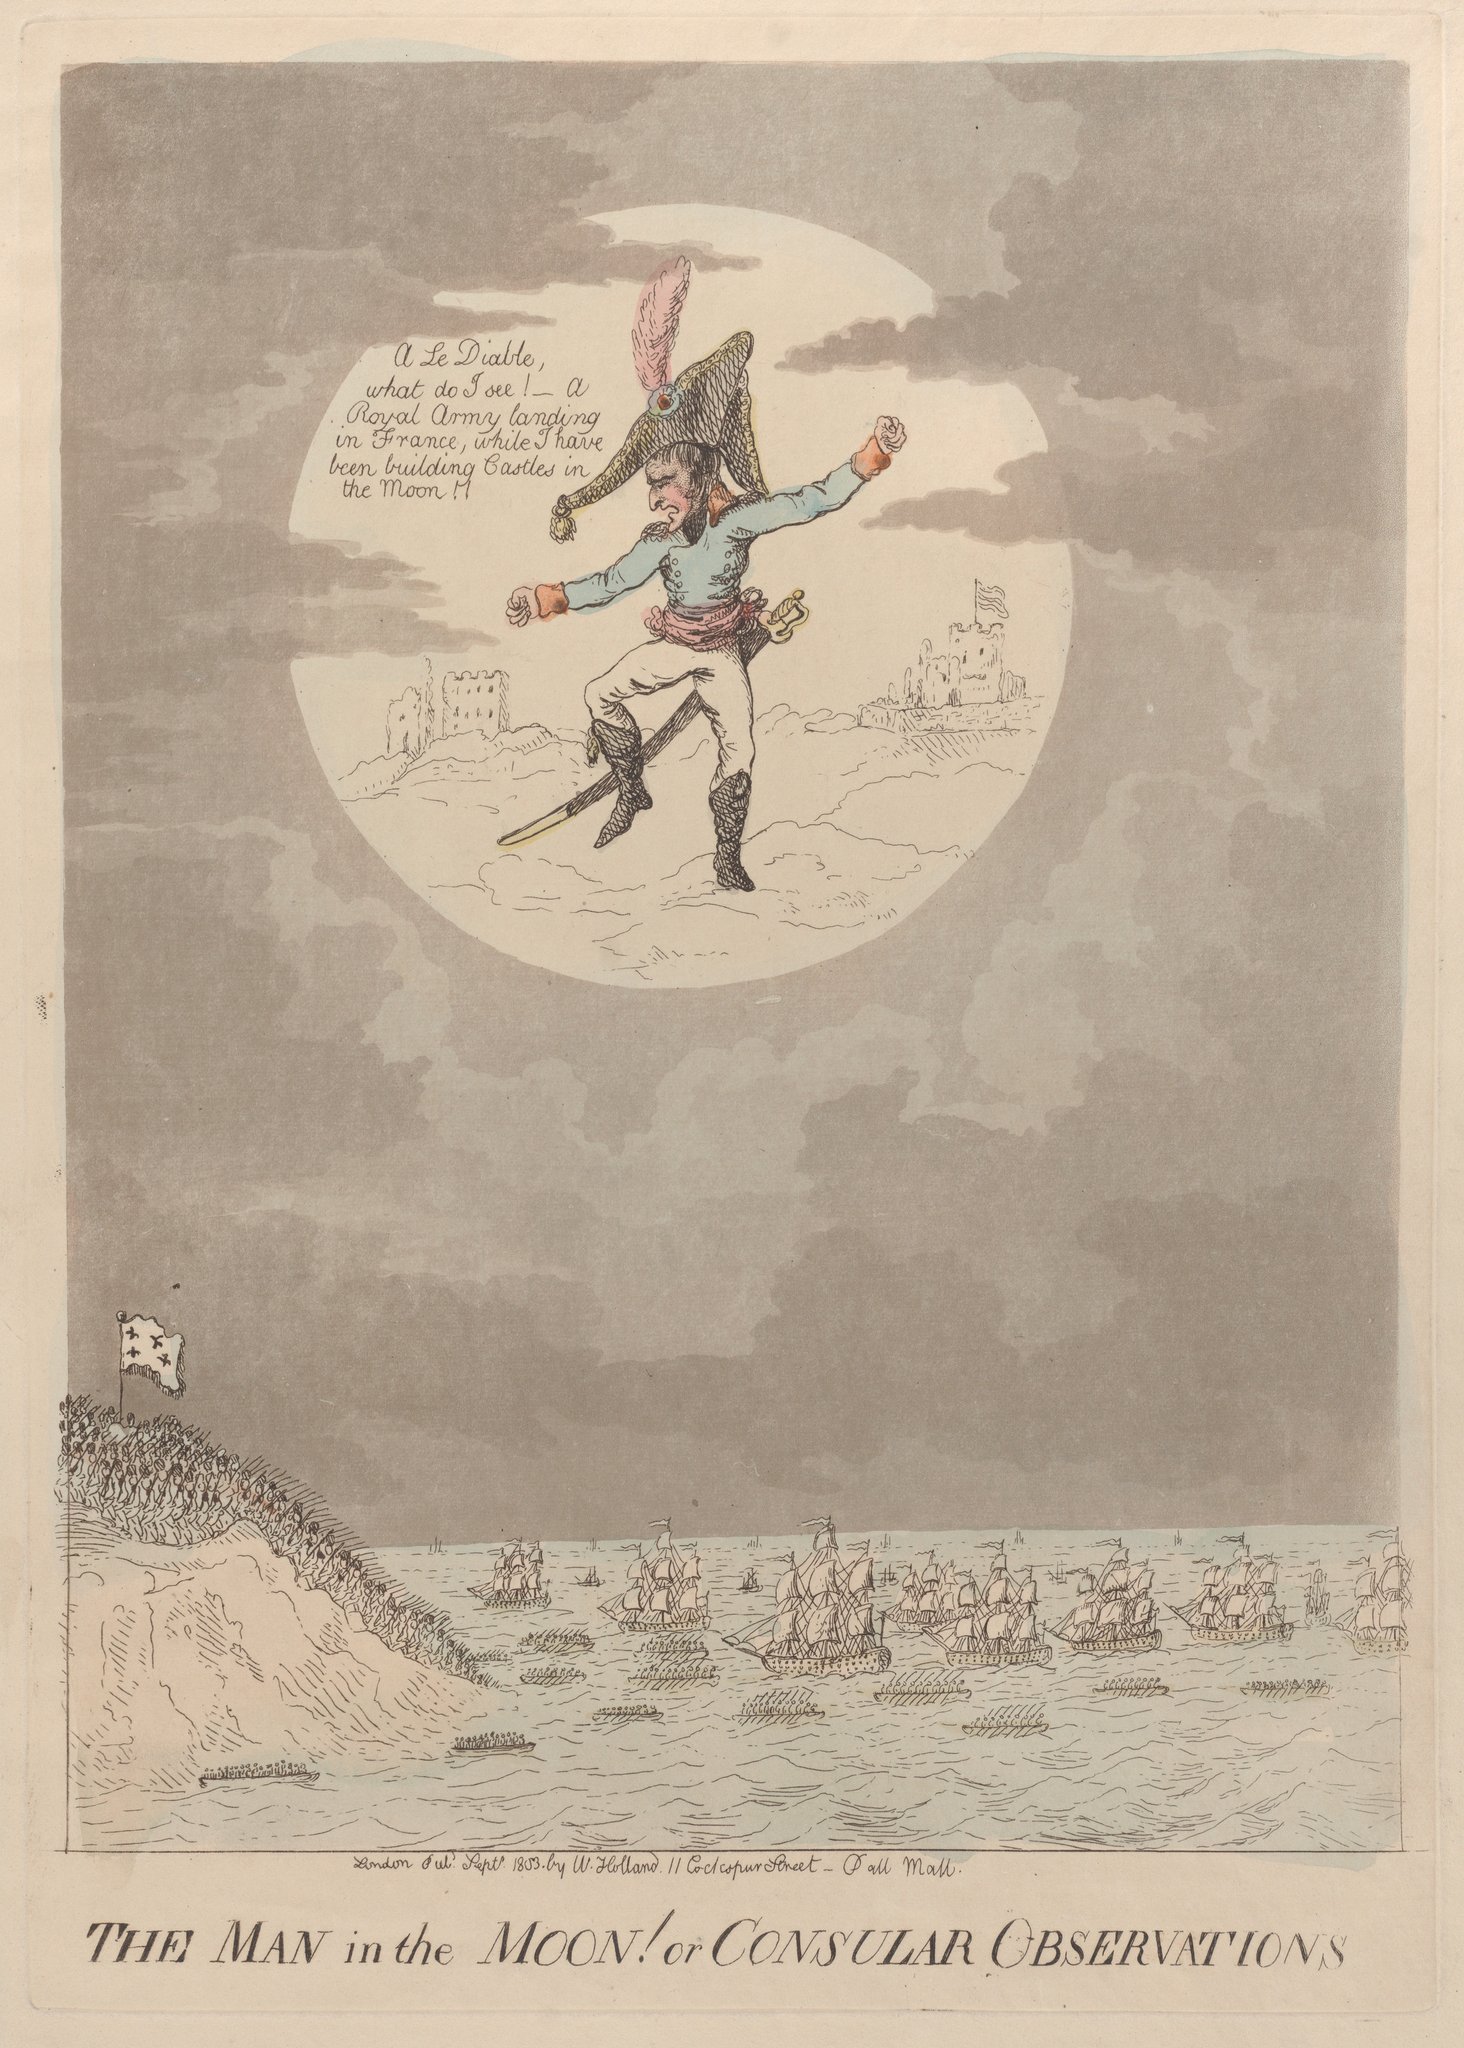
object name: print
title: The Man in the Moon! or Consular Observations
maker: isaac cruikshank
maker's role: artist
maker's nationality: british, scottish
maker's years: 1764-1811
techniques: aquatint, etching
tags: satire,napoleon i,ships,politics